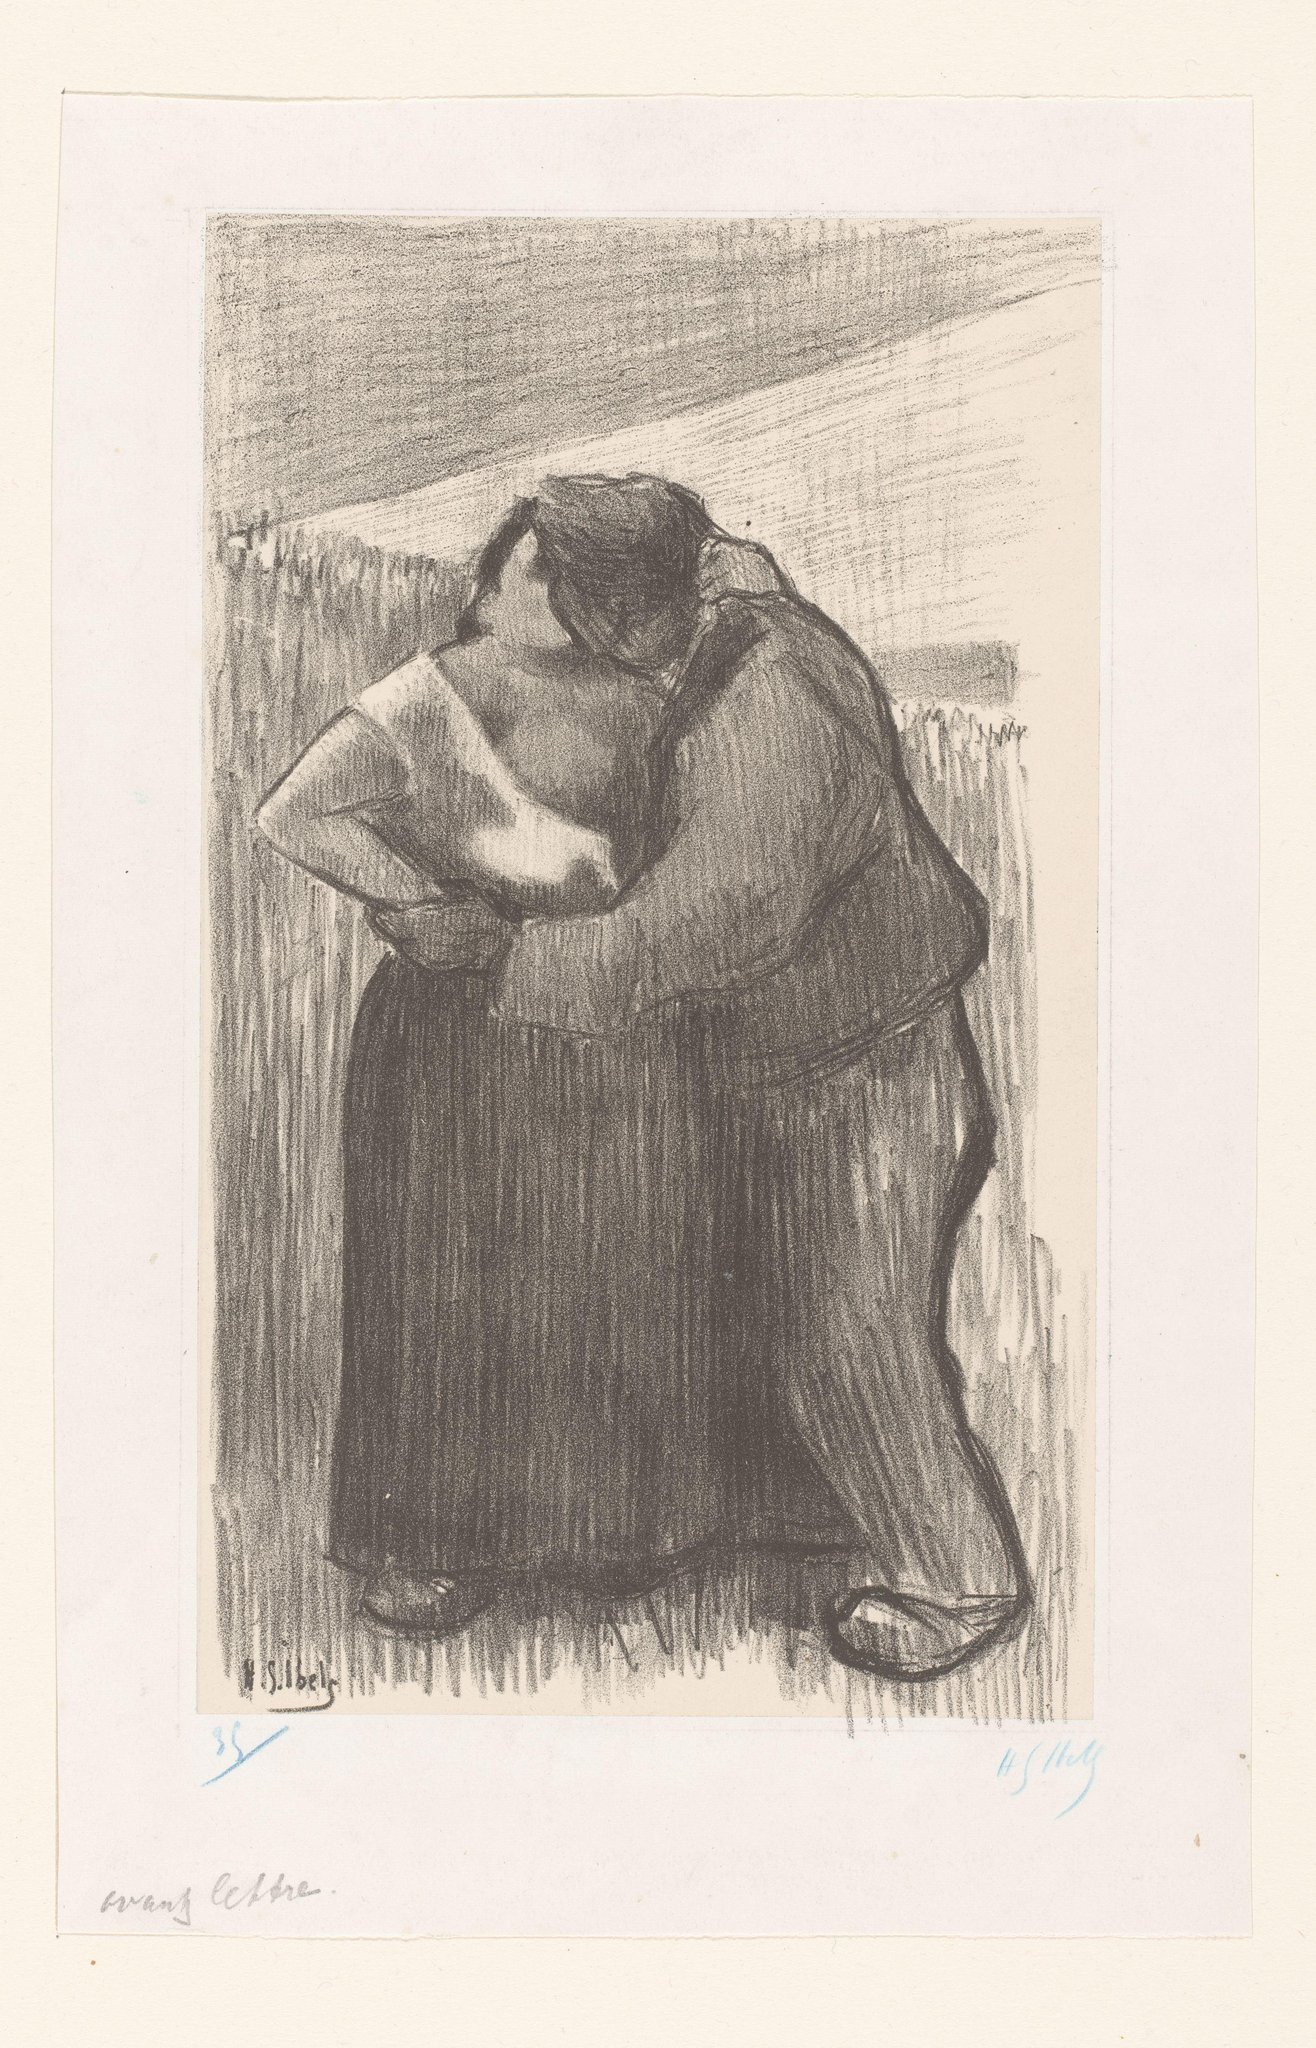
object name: print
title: Les Culs-Terreux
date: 1893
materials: paper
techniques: lithography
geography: paris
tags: (lovers) kissing each other, farmers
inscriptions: collector's mark: Lugt 2228a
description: Illustratie bij het muziekstuk Les Culs-Terreux van René Esse en Léopold Gangloff.